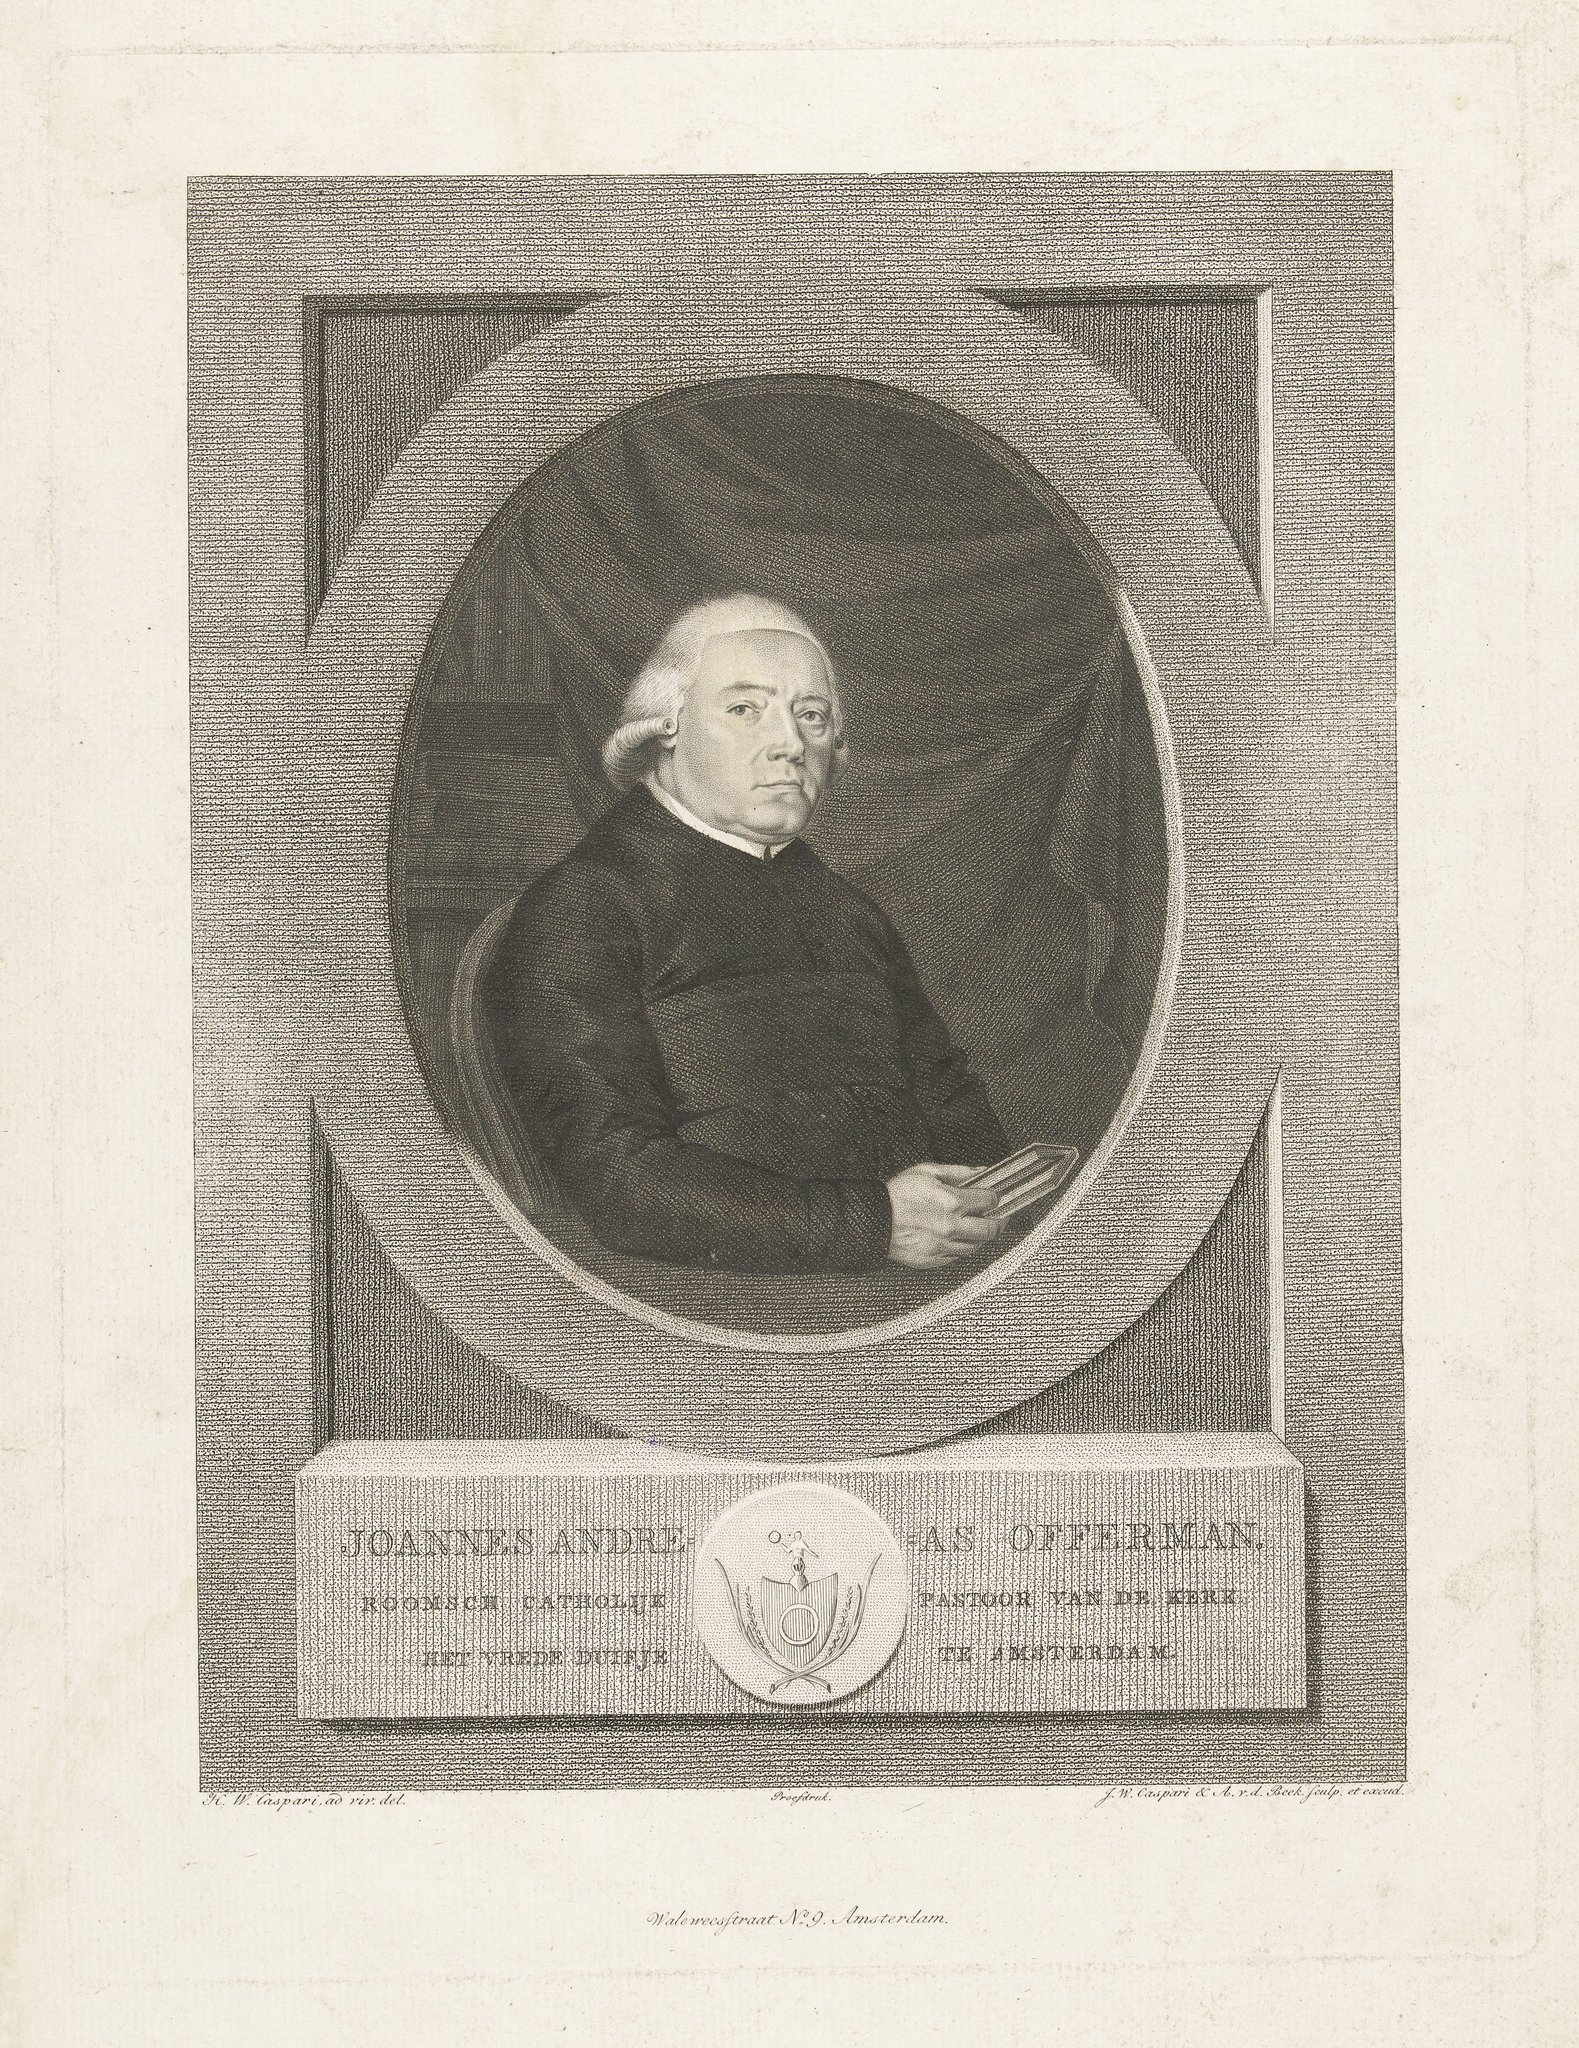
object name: print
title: Portret van Joës Andreas Offerman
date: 1789-1822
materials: paper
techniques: etching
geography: amsterdam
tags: priest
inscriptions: collector's mark: Lugt 2228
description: Portret in ovale lijst van Joës Andreas Offerman, pastoor van de Amsterdamse Sint-Willibrorduskerk binnen de Veste (Het Vrededuifje). Buste naar rechts. Offerman draagt een soutane met een witte priesterboord.. Hij heeft een boek in de rechterhand. Op de achtergrond een boekenkast. De prent heeft een Nederlands onderschrift met de naam van de geportretteerde en een cartouche met daarin de afbeelding van een duif.